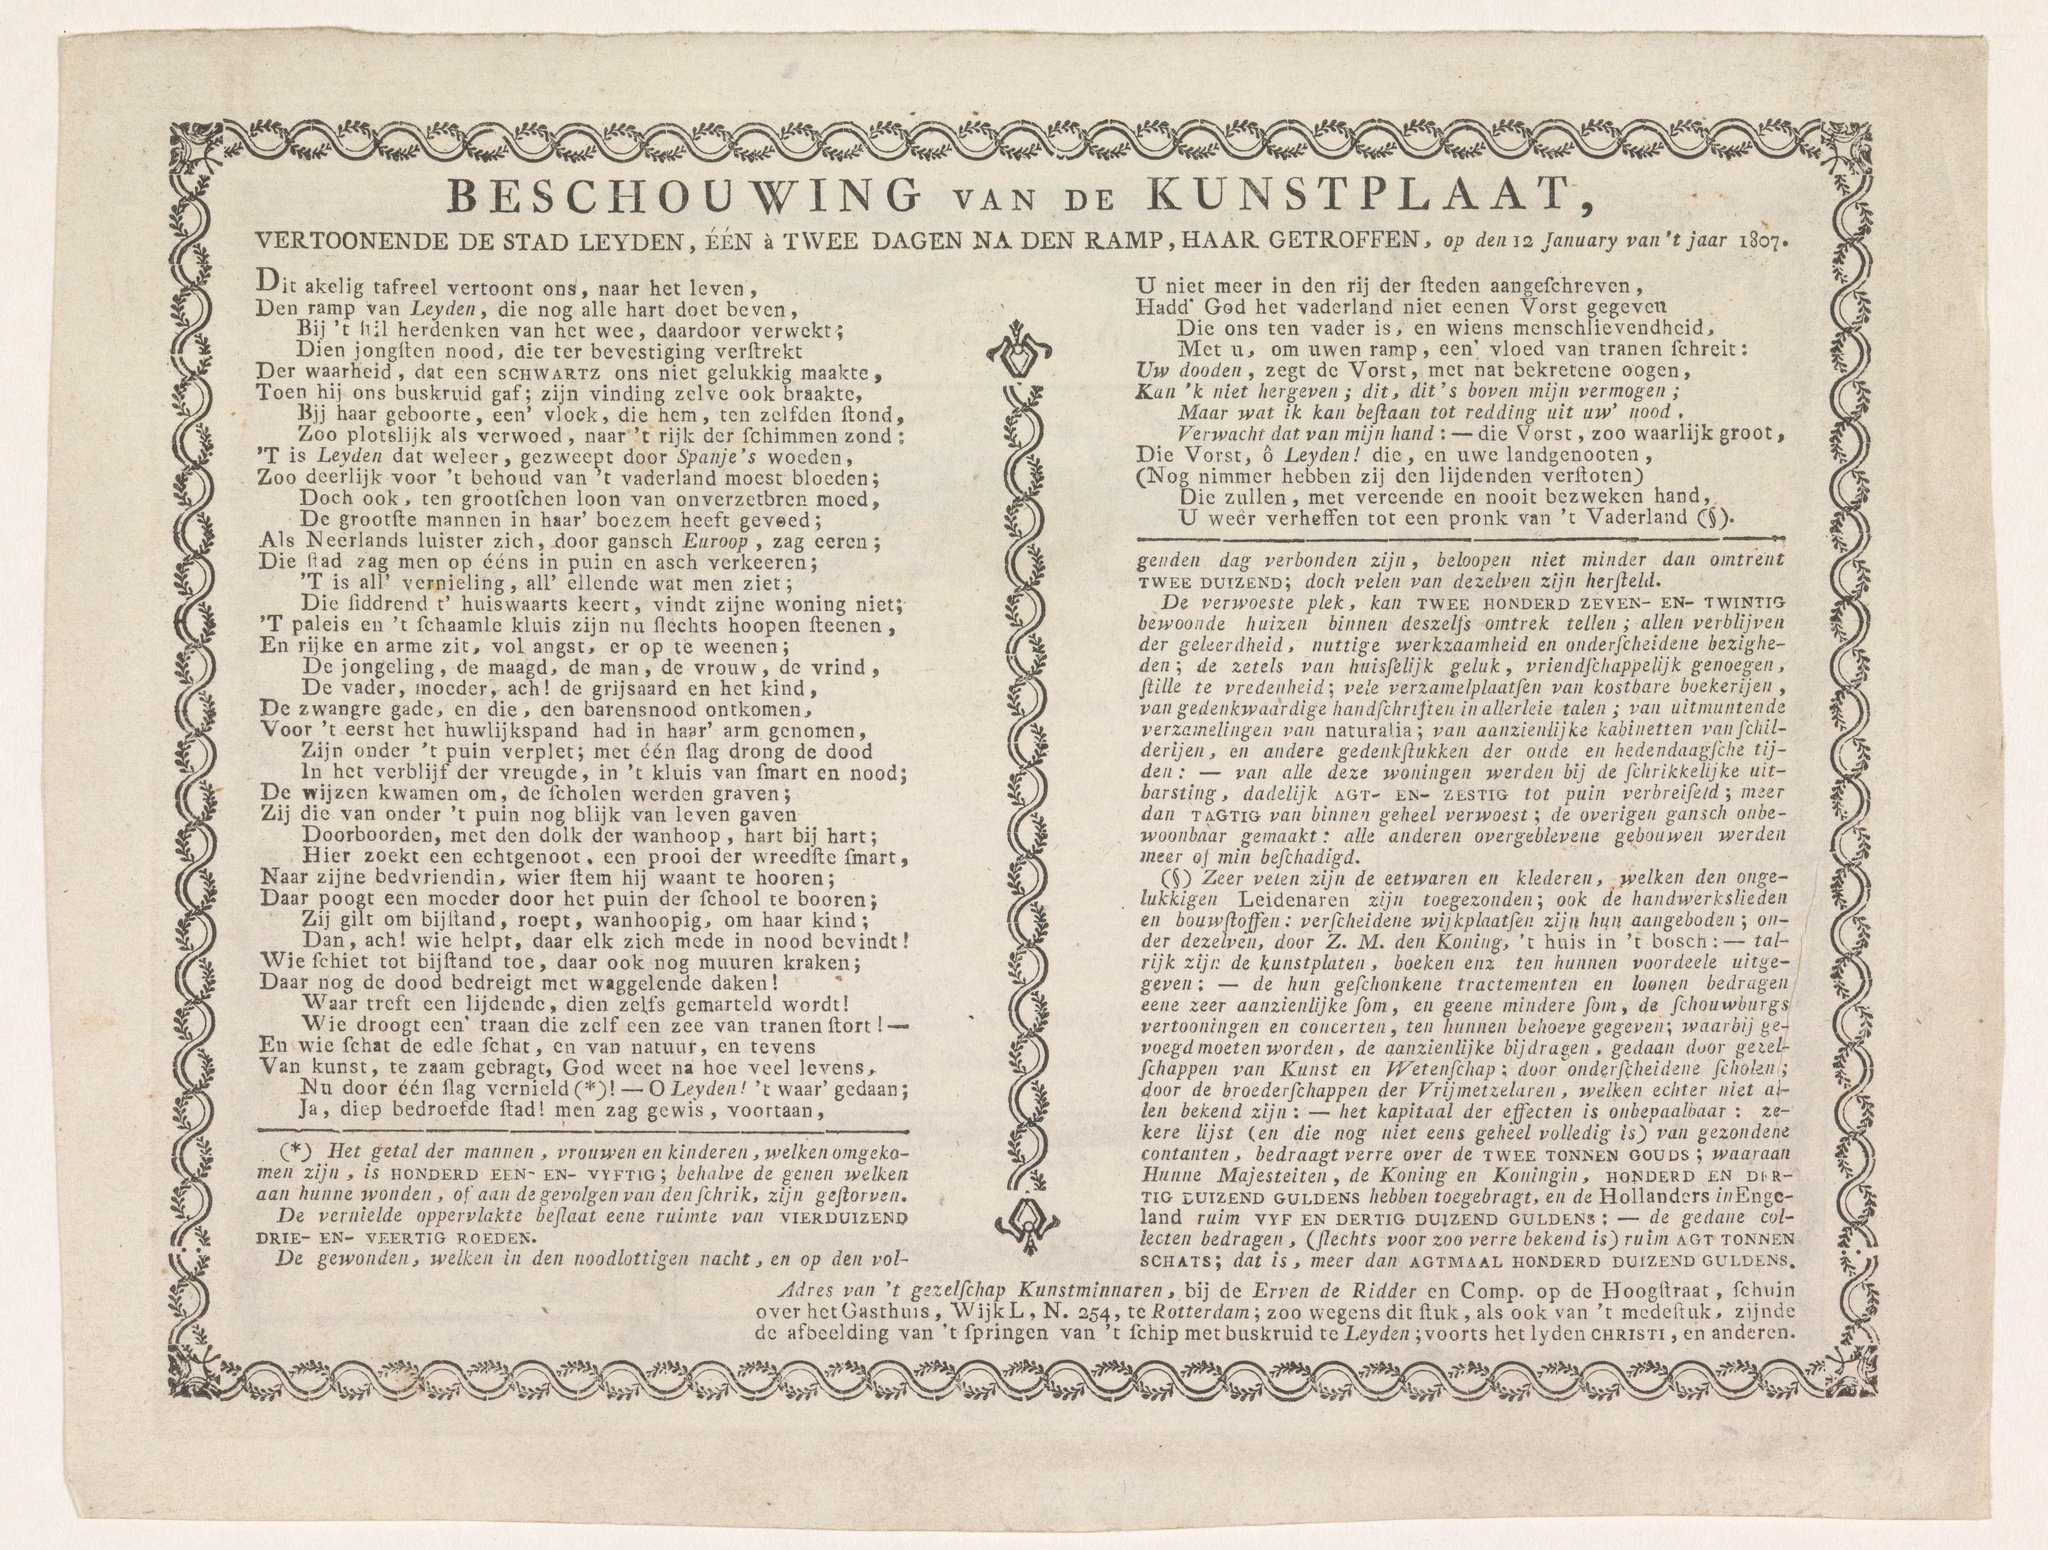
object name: text sheet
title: Vers op een prent van de Leidse buskruitramp, 1807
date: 1807-1808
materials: paper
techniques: letterpress printing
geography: rotterdam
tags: gunpowder disaster, leiden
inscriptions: collector's mark: Lugt 2228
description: Tekstblad met een vers in twee kolommen op een afbeelding van de buskruitramp in Leiden op 12 januari 1807. De prent waar het vers op betrekking heeft ontbreekt.